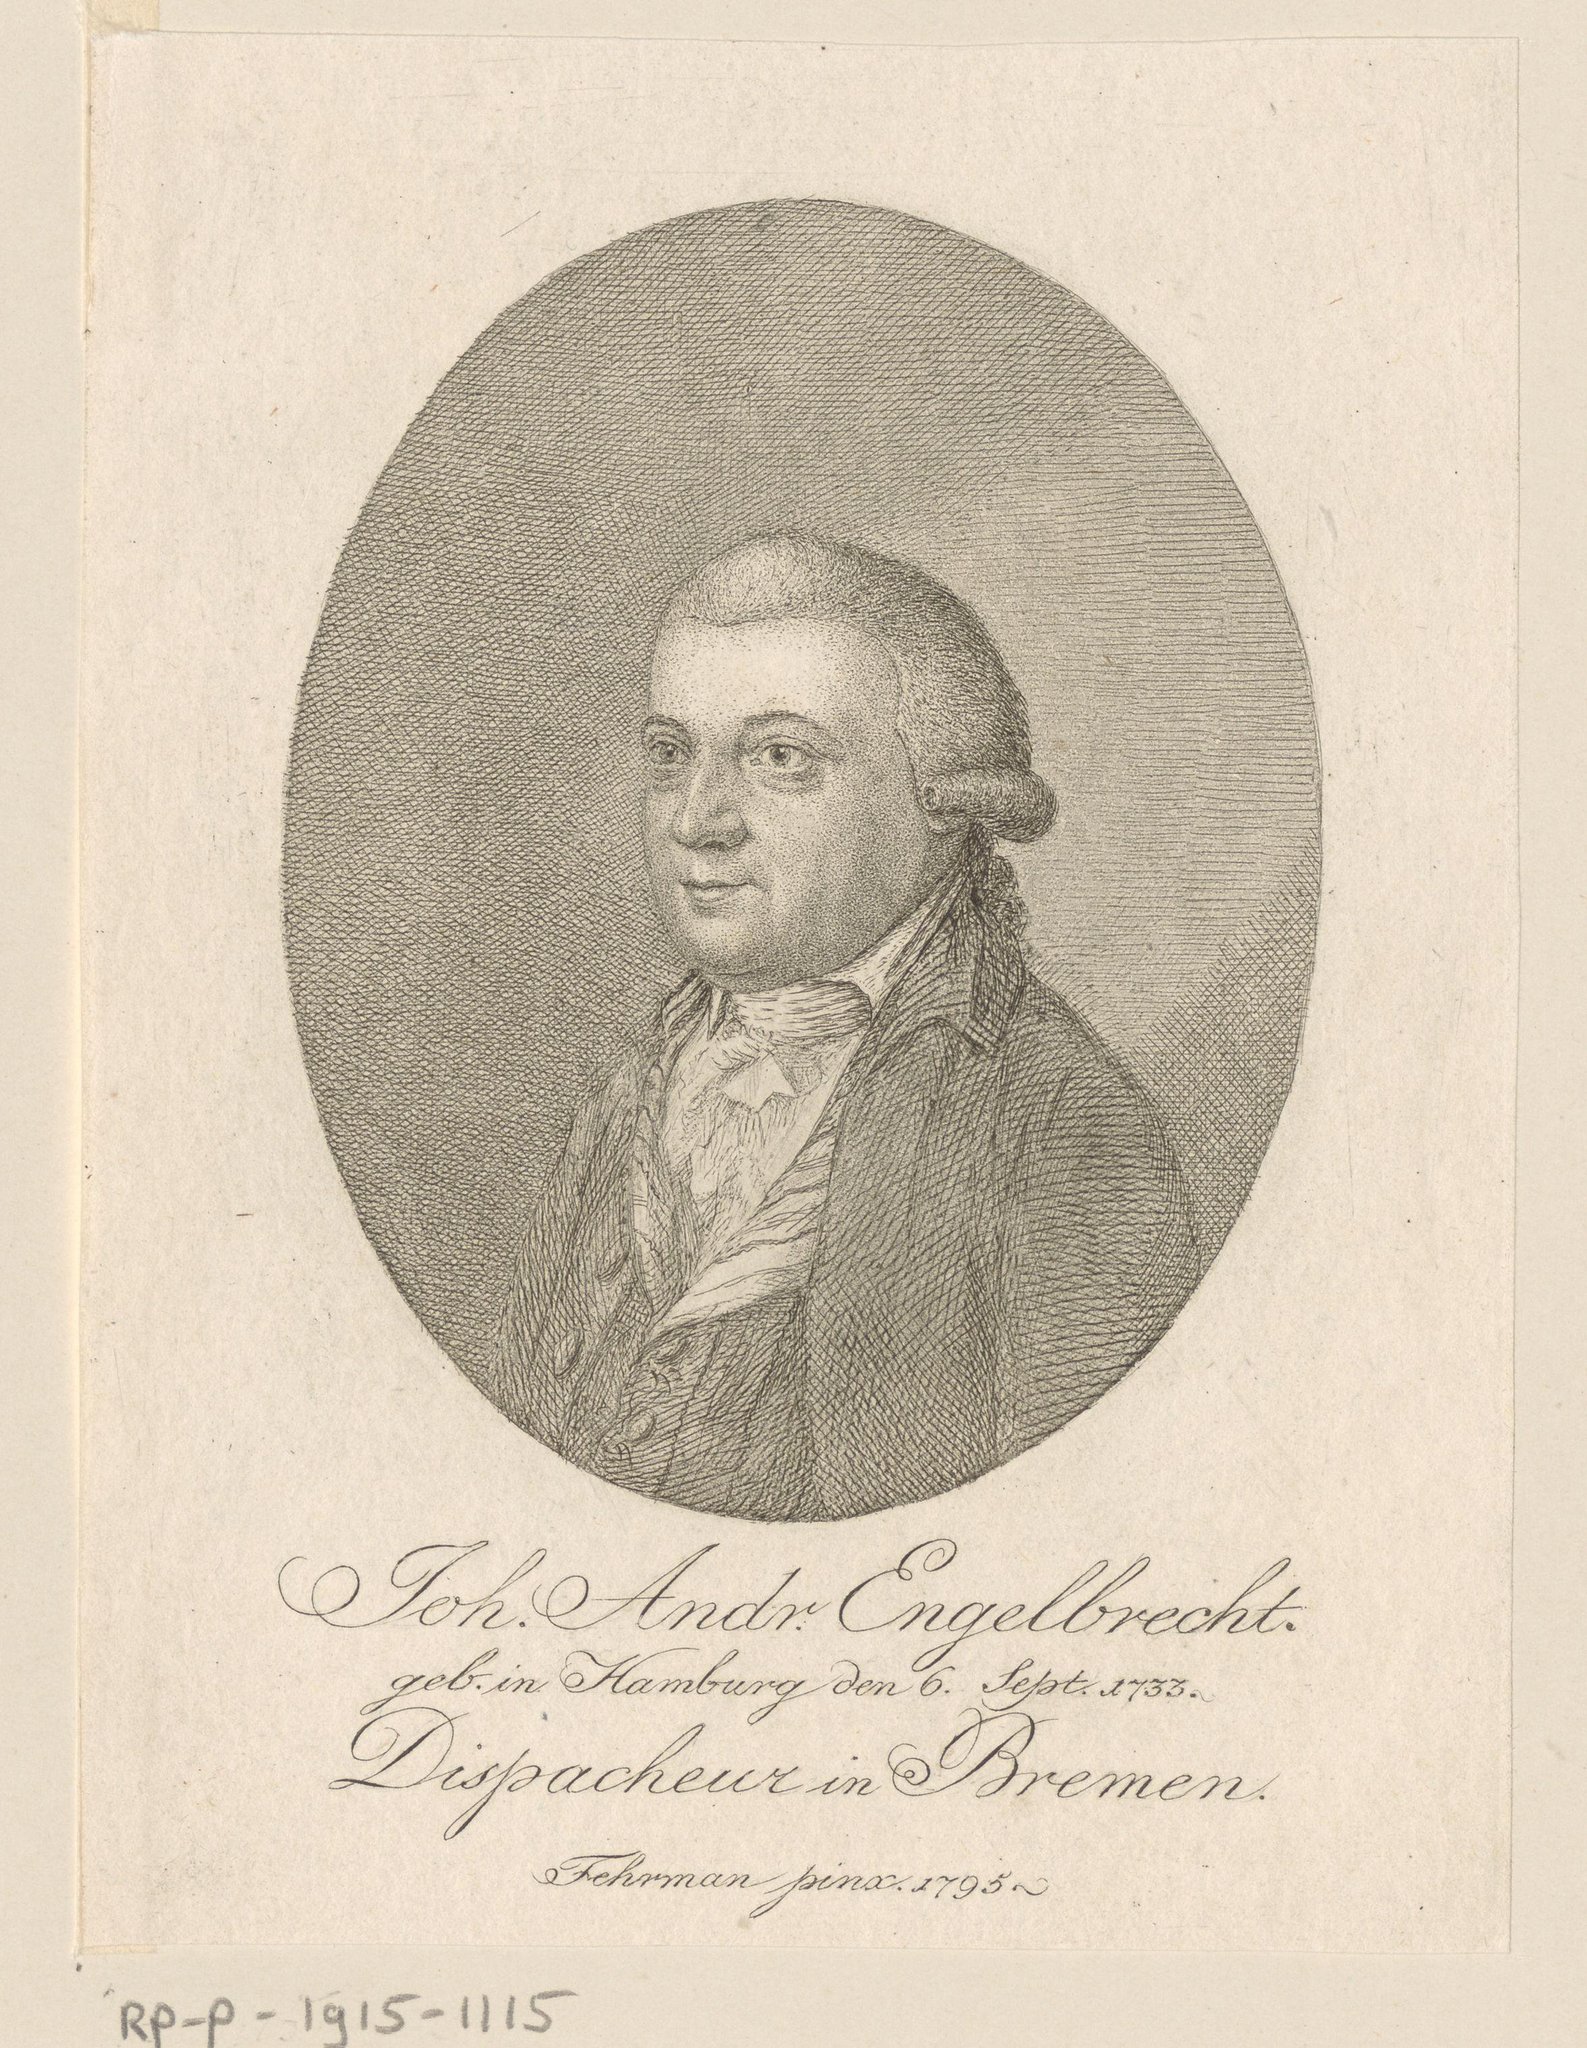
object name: print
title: Portret van Johann Andreas Engelbrecht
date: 1795-1797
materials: paper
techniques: etching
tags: berlin, historical persons, portrait of a writer